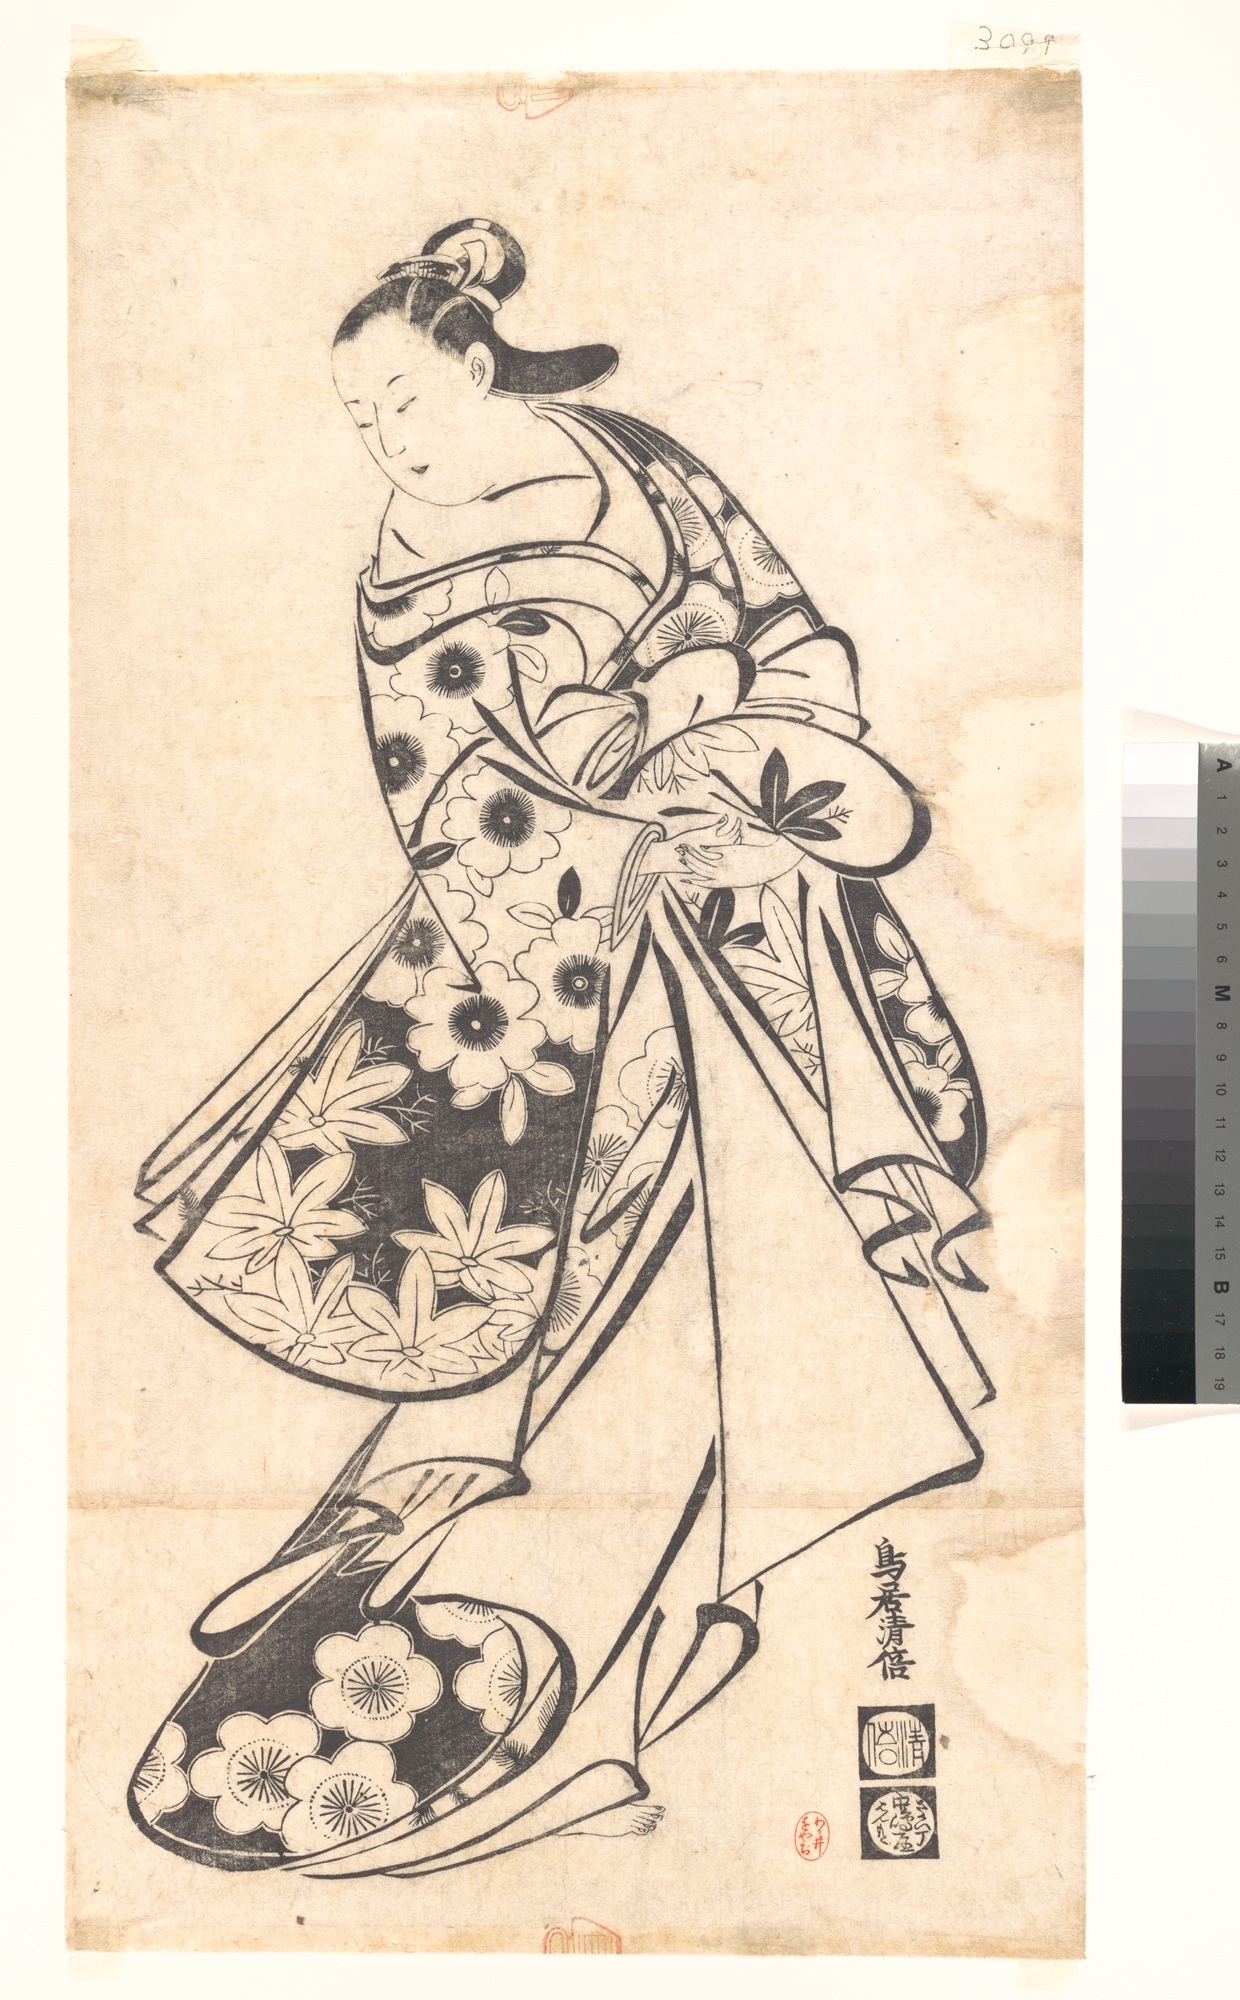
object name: print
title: Courtesan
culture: japanese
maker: torii kiyomasu i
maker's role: artist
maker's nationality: japanese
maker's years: 1696-1716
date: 1712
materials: ink, paper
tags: women